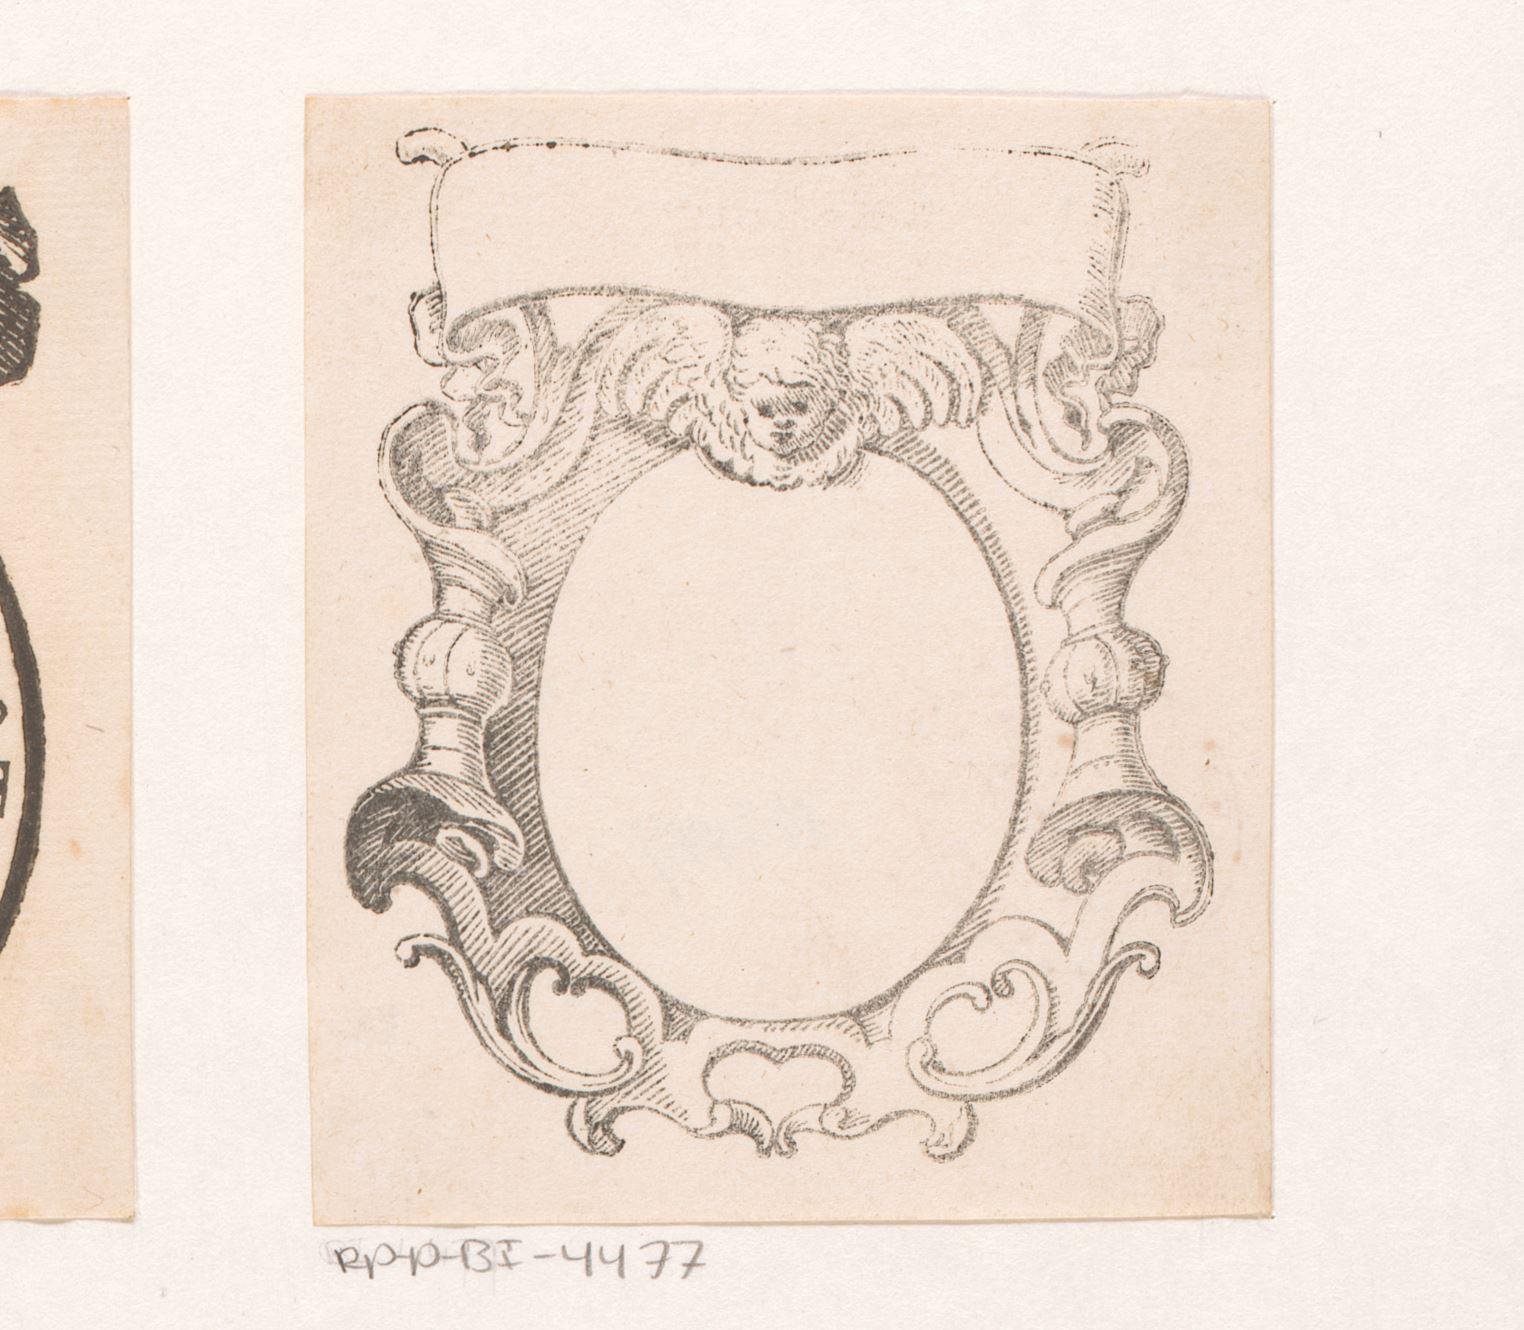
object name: print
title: Vignet met een geornamenteerd ovaal met een cherubijn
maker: Anonymous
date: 1600-1699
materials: paper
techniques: woodcut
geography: netherlands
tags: cherubs, i.e. children's heads with wings, vignette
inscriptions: collector's mark: Lugt 240